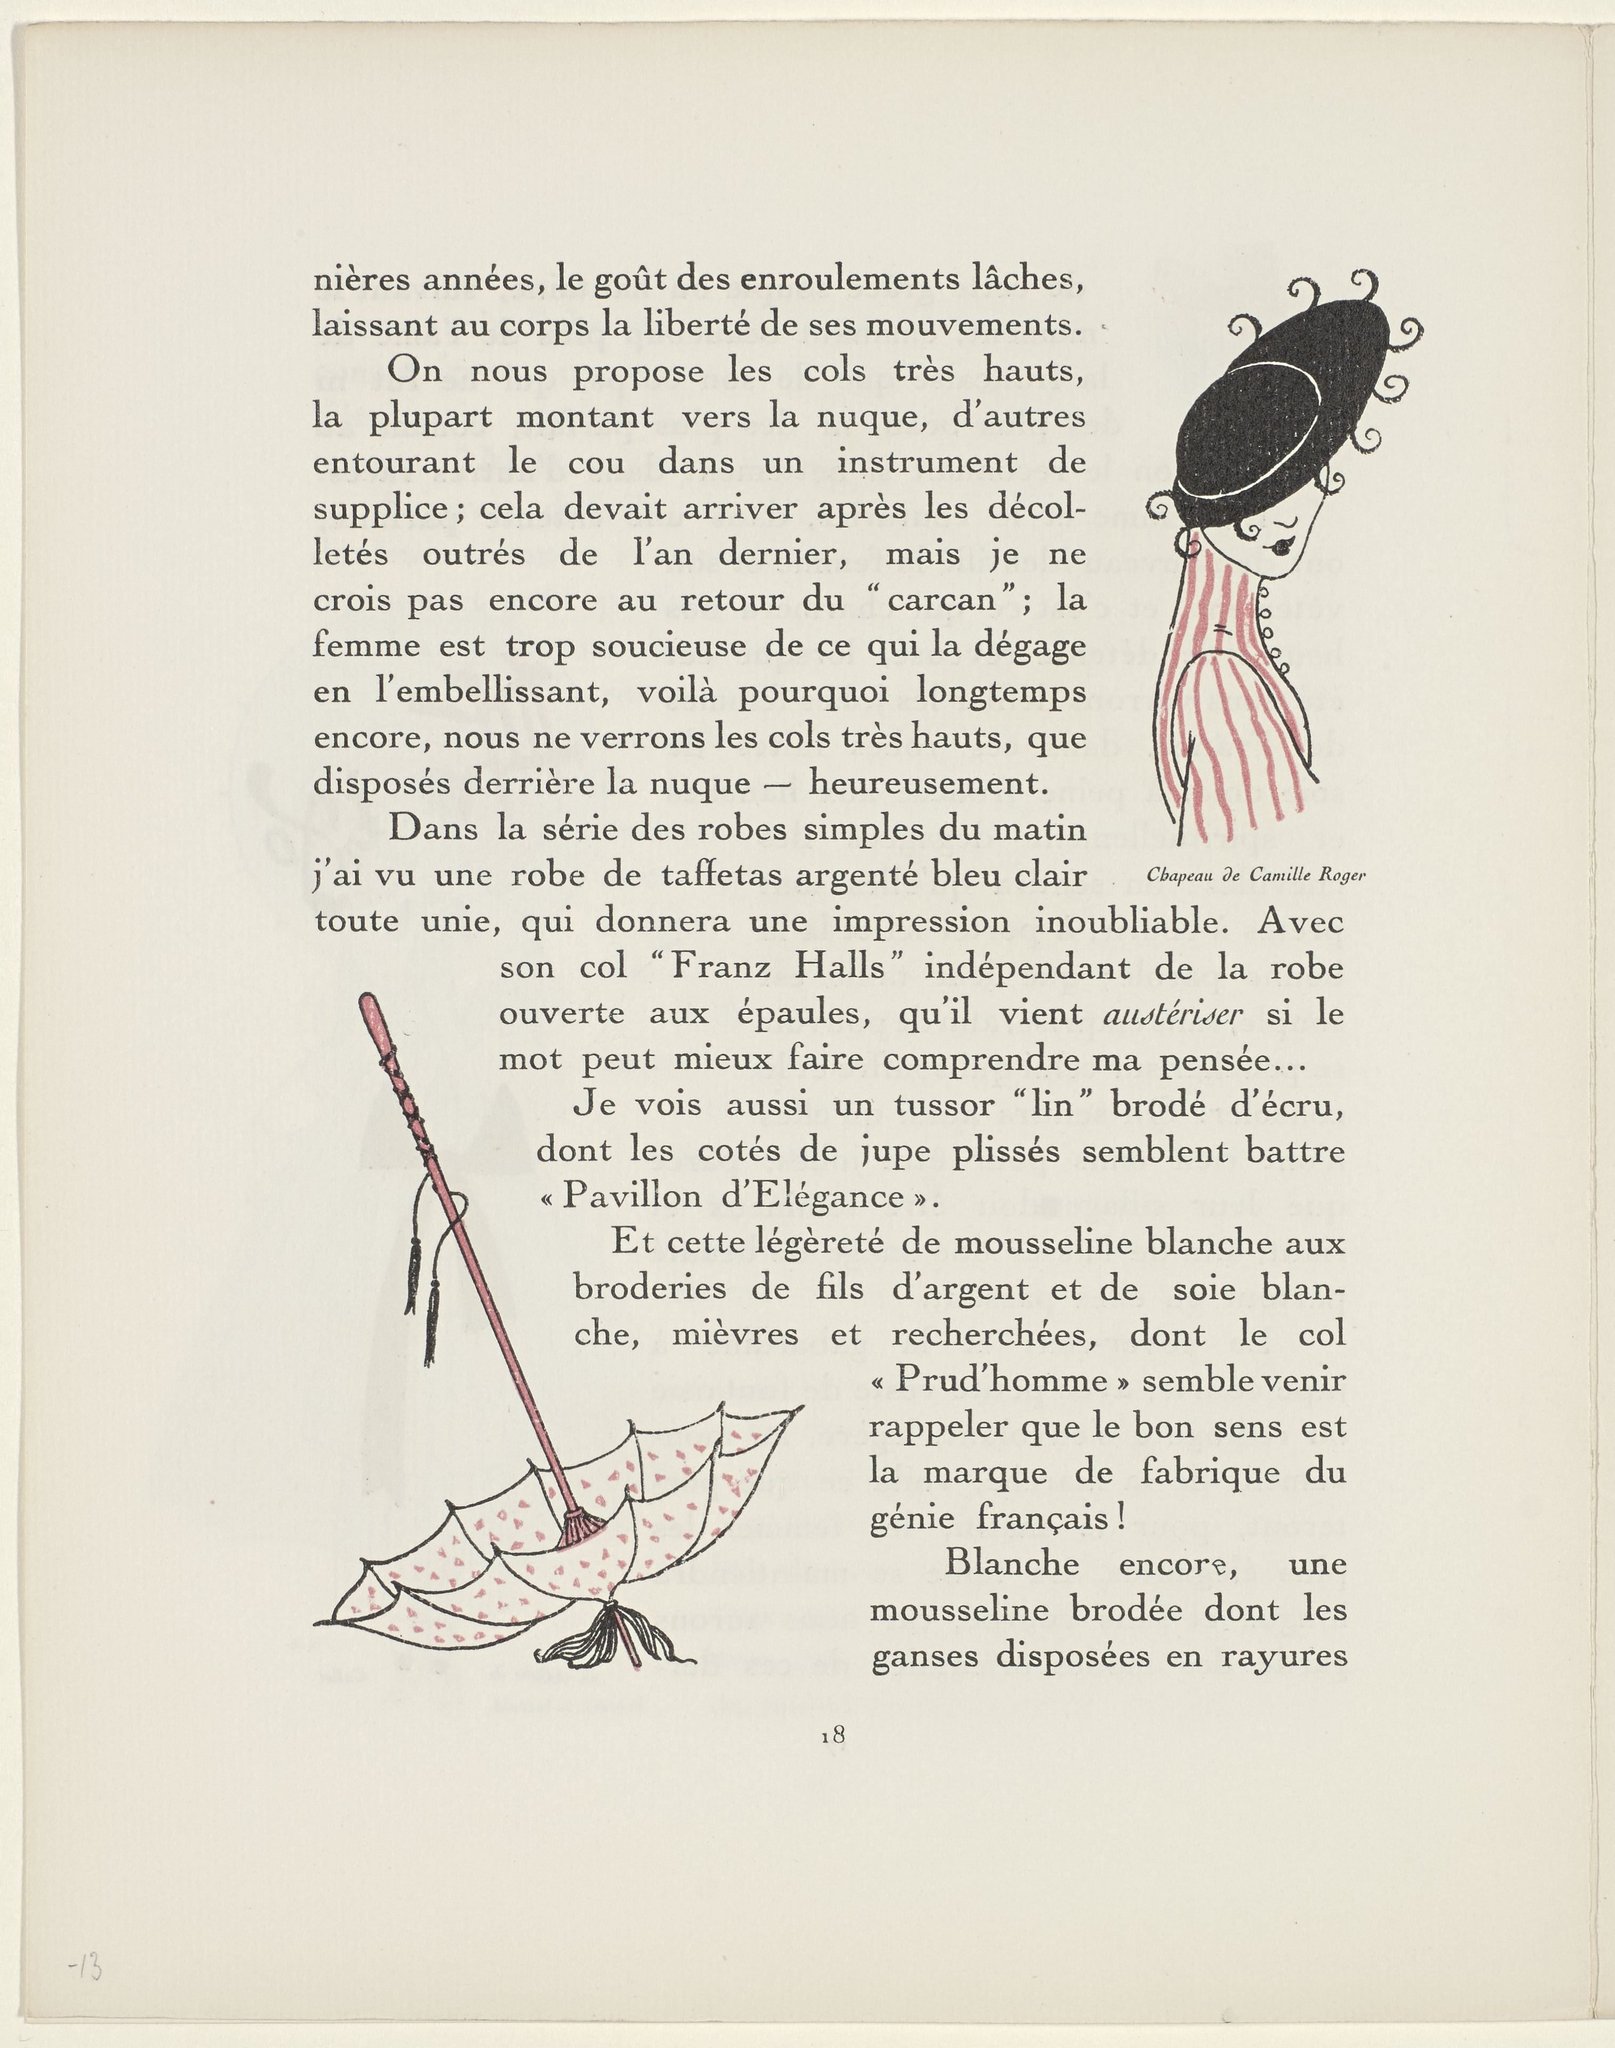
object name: fashion print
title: Gazette du Bon Ton, 1915 - No. 8-9, p. 18: Autours Simples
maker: lucien vogel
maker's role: publisher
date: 1915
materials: paper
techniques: hand coloring, letterpress printing, photochemical processes, pochoir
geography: paris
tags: fashion plates, head-gear: hat (+ women's clothes), umbrella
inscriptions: date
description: Gazette du Bon Ton 1915, No. 8-9, pag. 18: Tekst met illustratie: "Chapeau de Camille Roger" en omgekeerde parasol